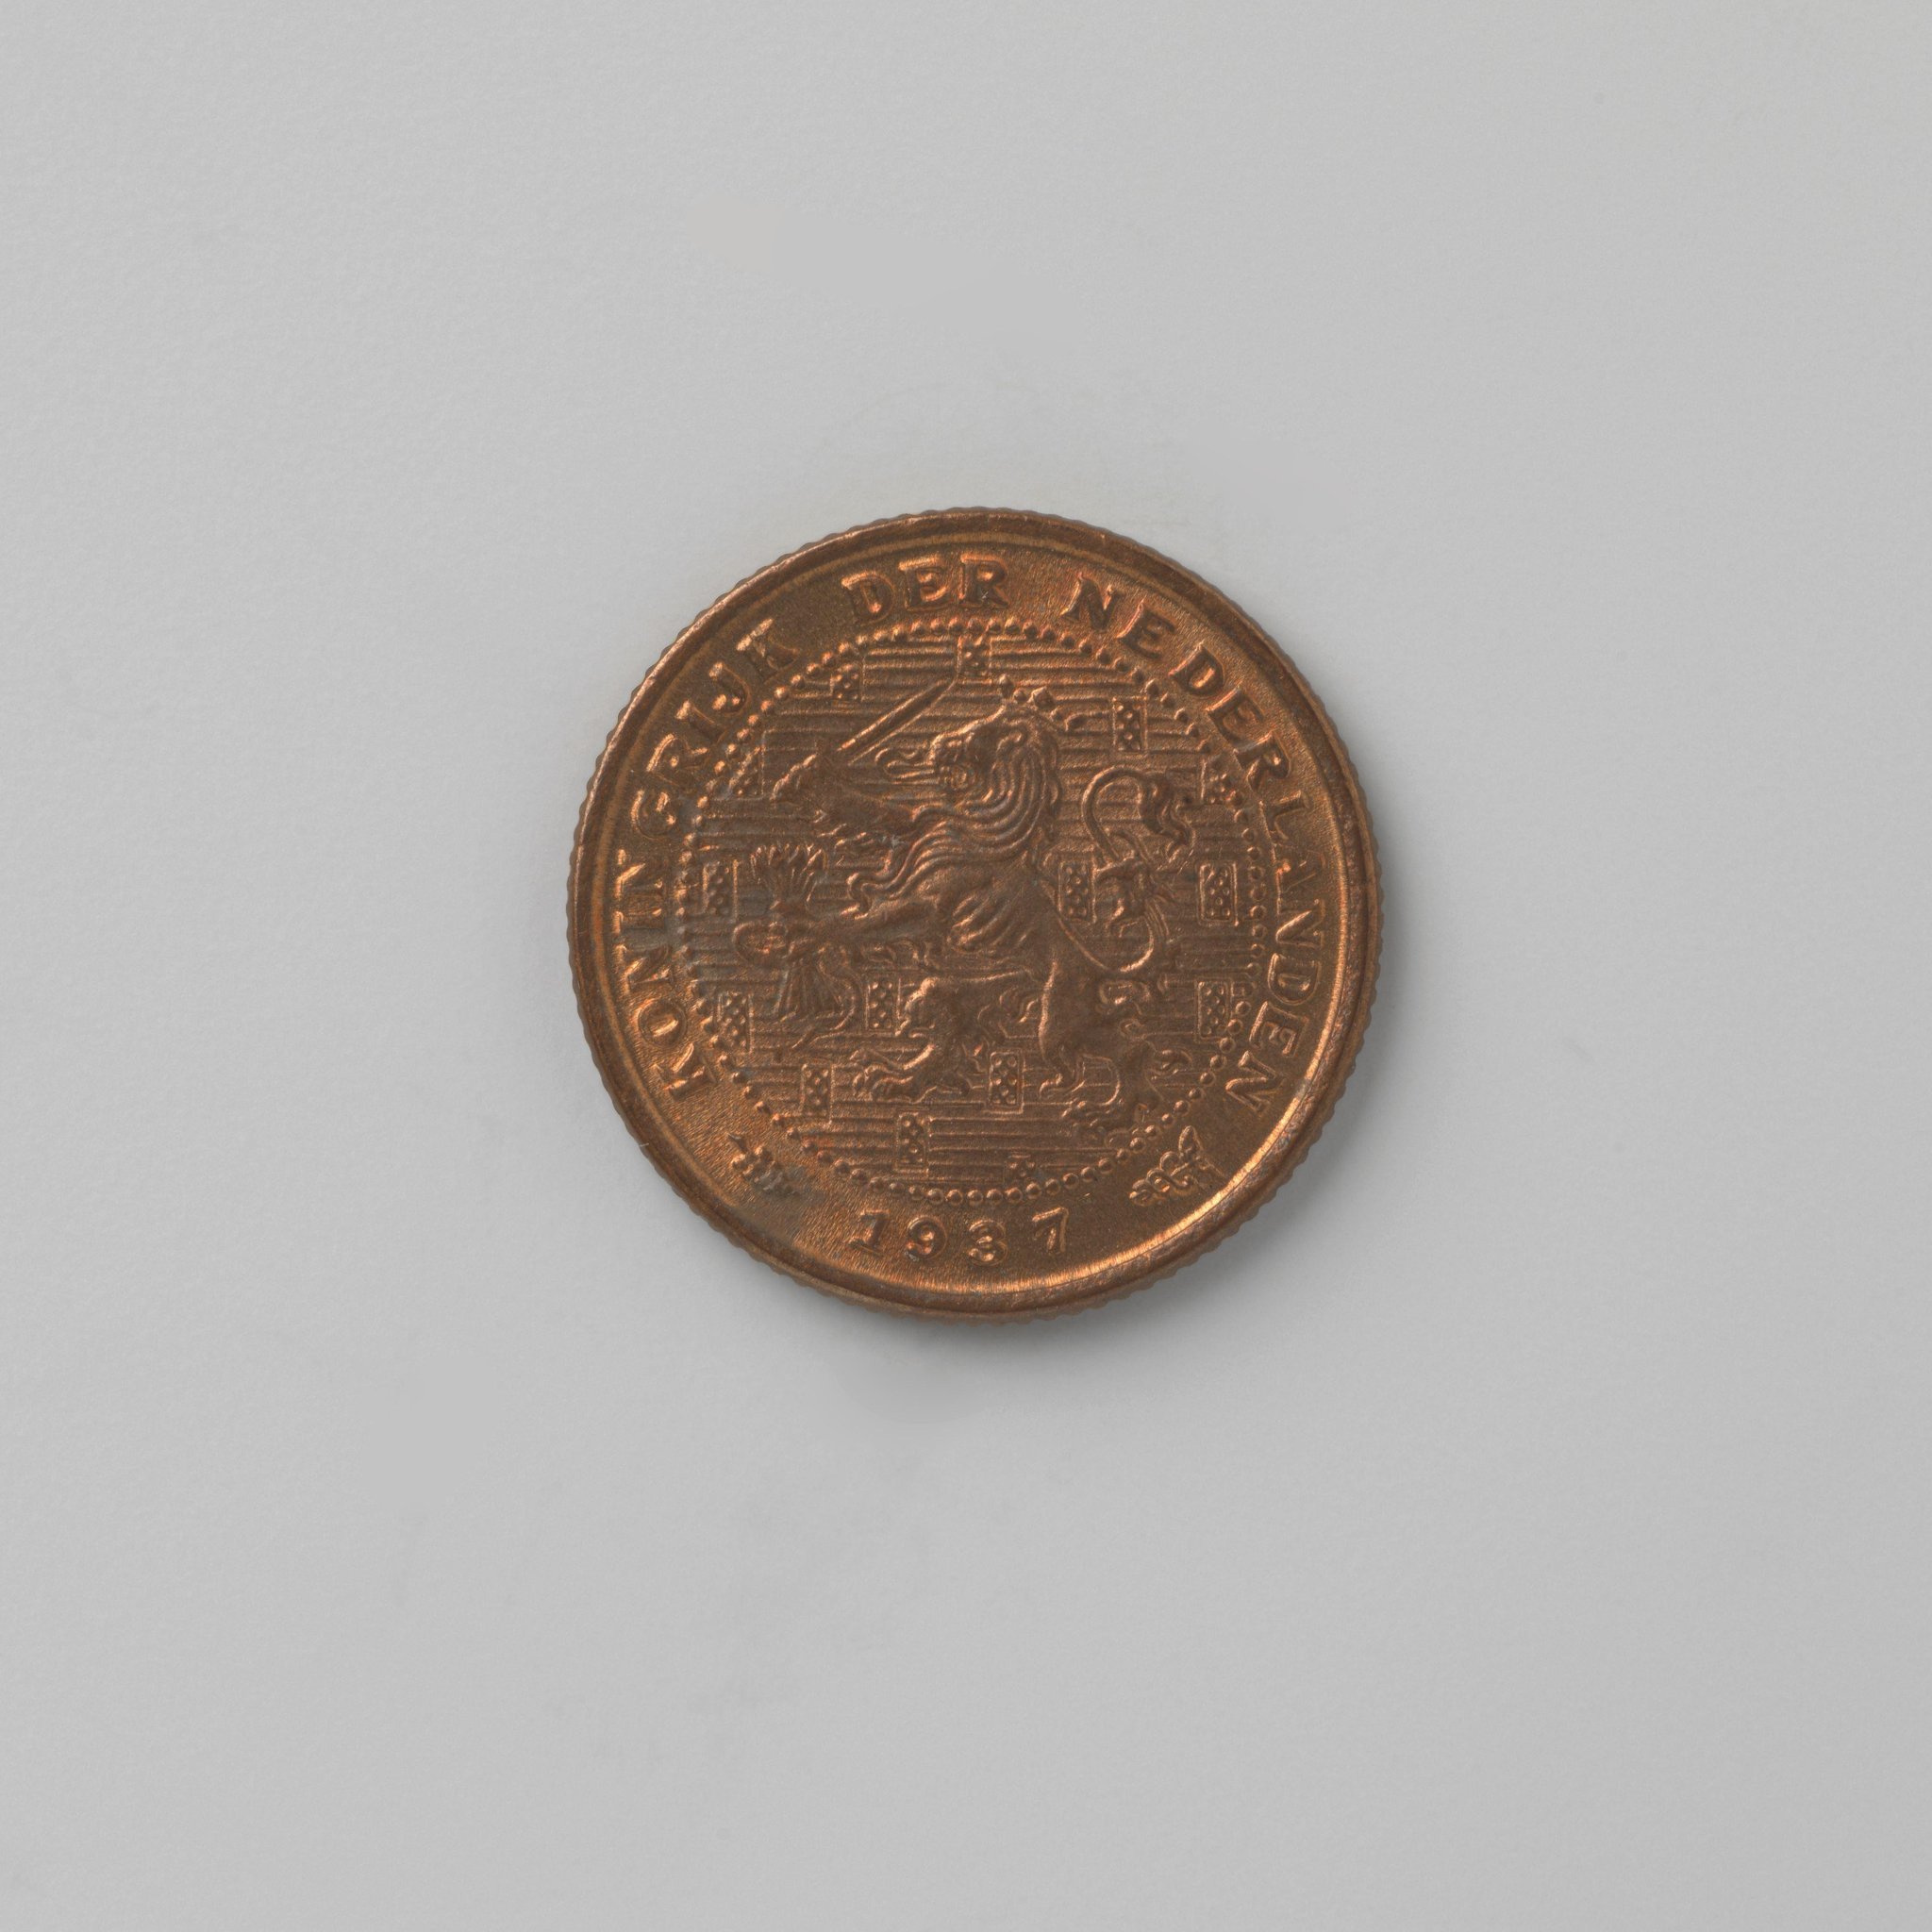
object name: coin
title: Nederlandse ½ cent,1937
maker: wilhelmina of the netherlands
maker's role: print maker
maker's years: 1880-1962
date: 1937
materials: bronze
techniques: striking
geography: utrecht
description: Bronzen munt. Voorzijde: in een veld rijkswapen. Jaartal onderaan in omschrift. Keerzijde: binnen twee samengebonden oranjetakken waarde-aanduiding ½ cent. Kartelrand.